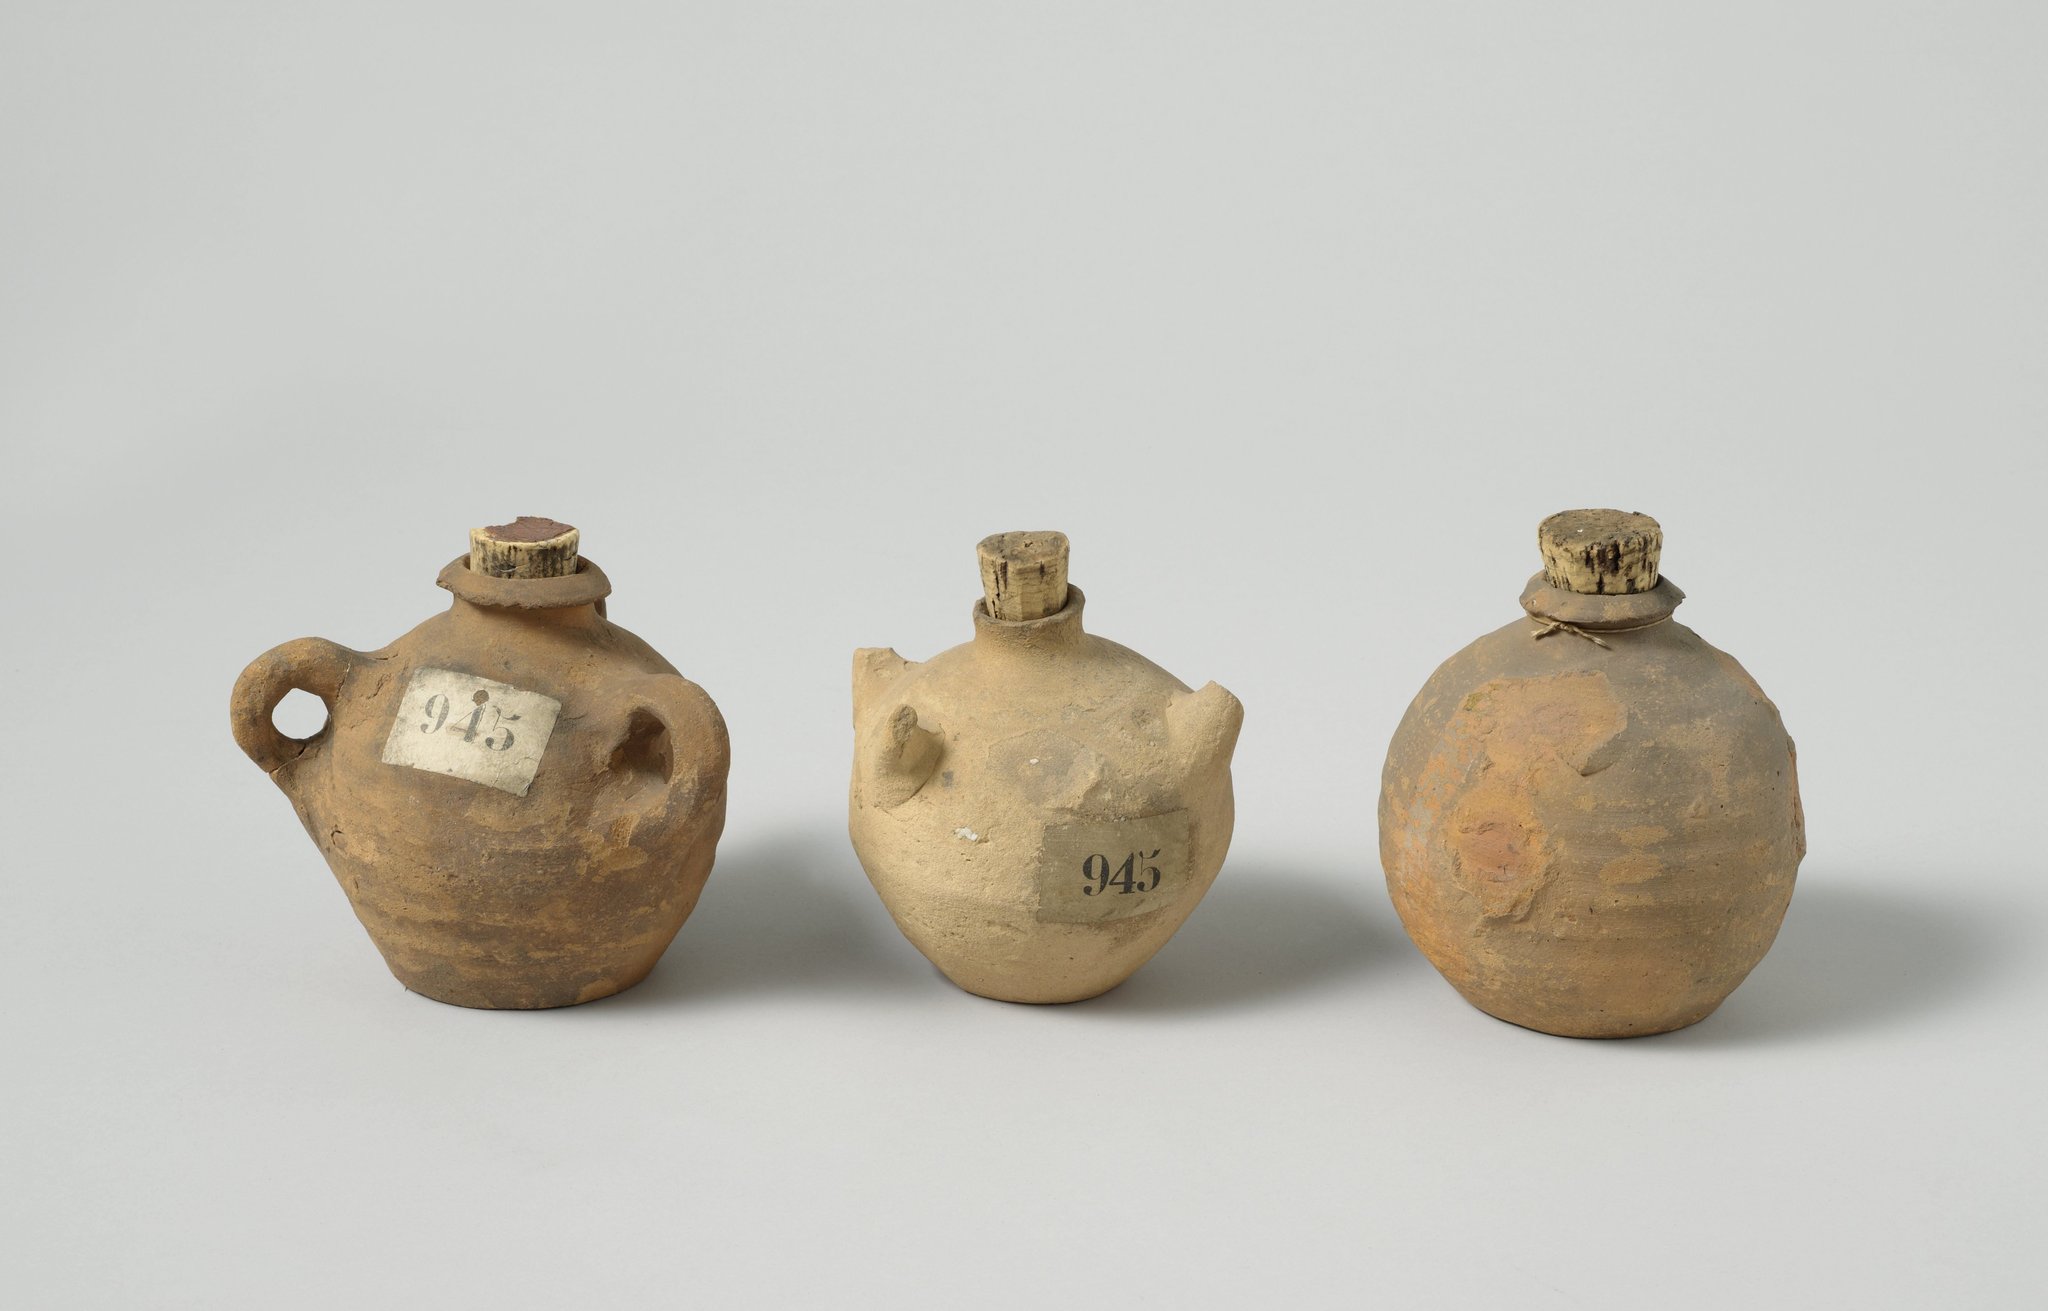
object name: fire pot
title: Three Fire Pots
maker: Anonymous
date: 1550-1700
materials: cork, earthenware, fuel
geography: netherlands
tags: flushing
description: Ronde aardewerken potten met een korte nek en drie verticaal geplaatste oren. Een van deze potten bevat nog resten van de oorspronkelijke inhoud.